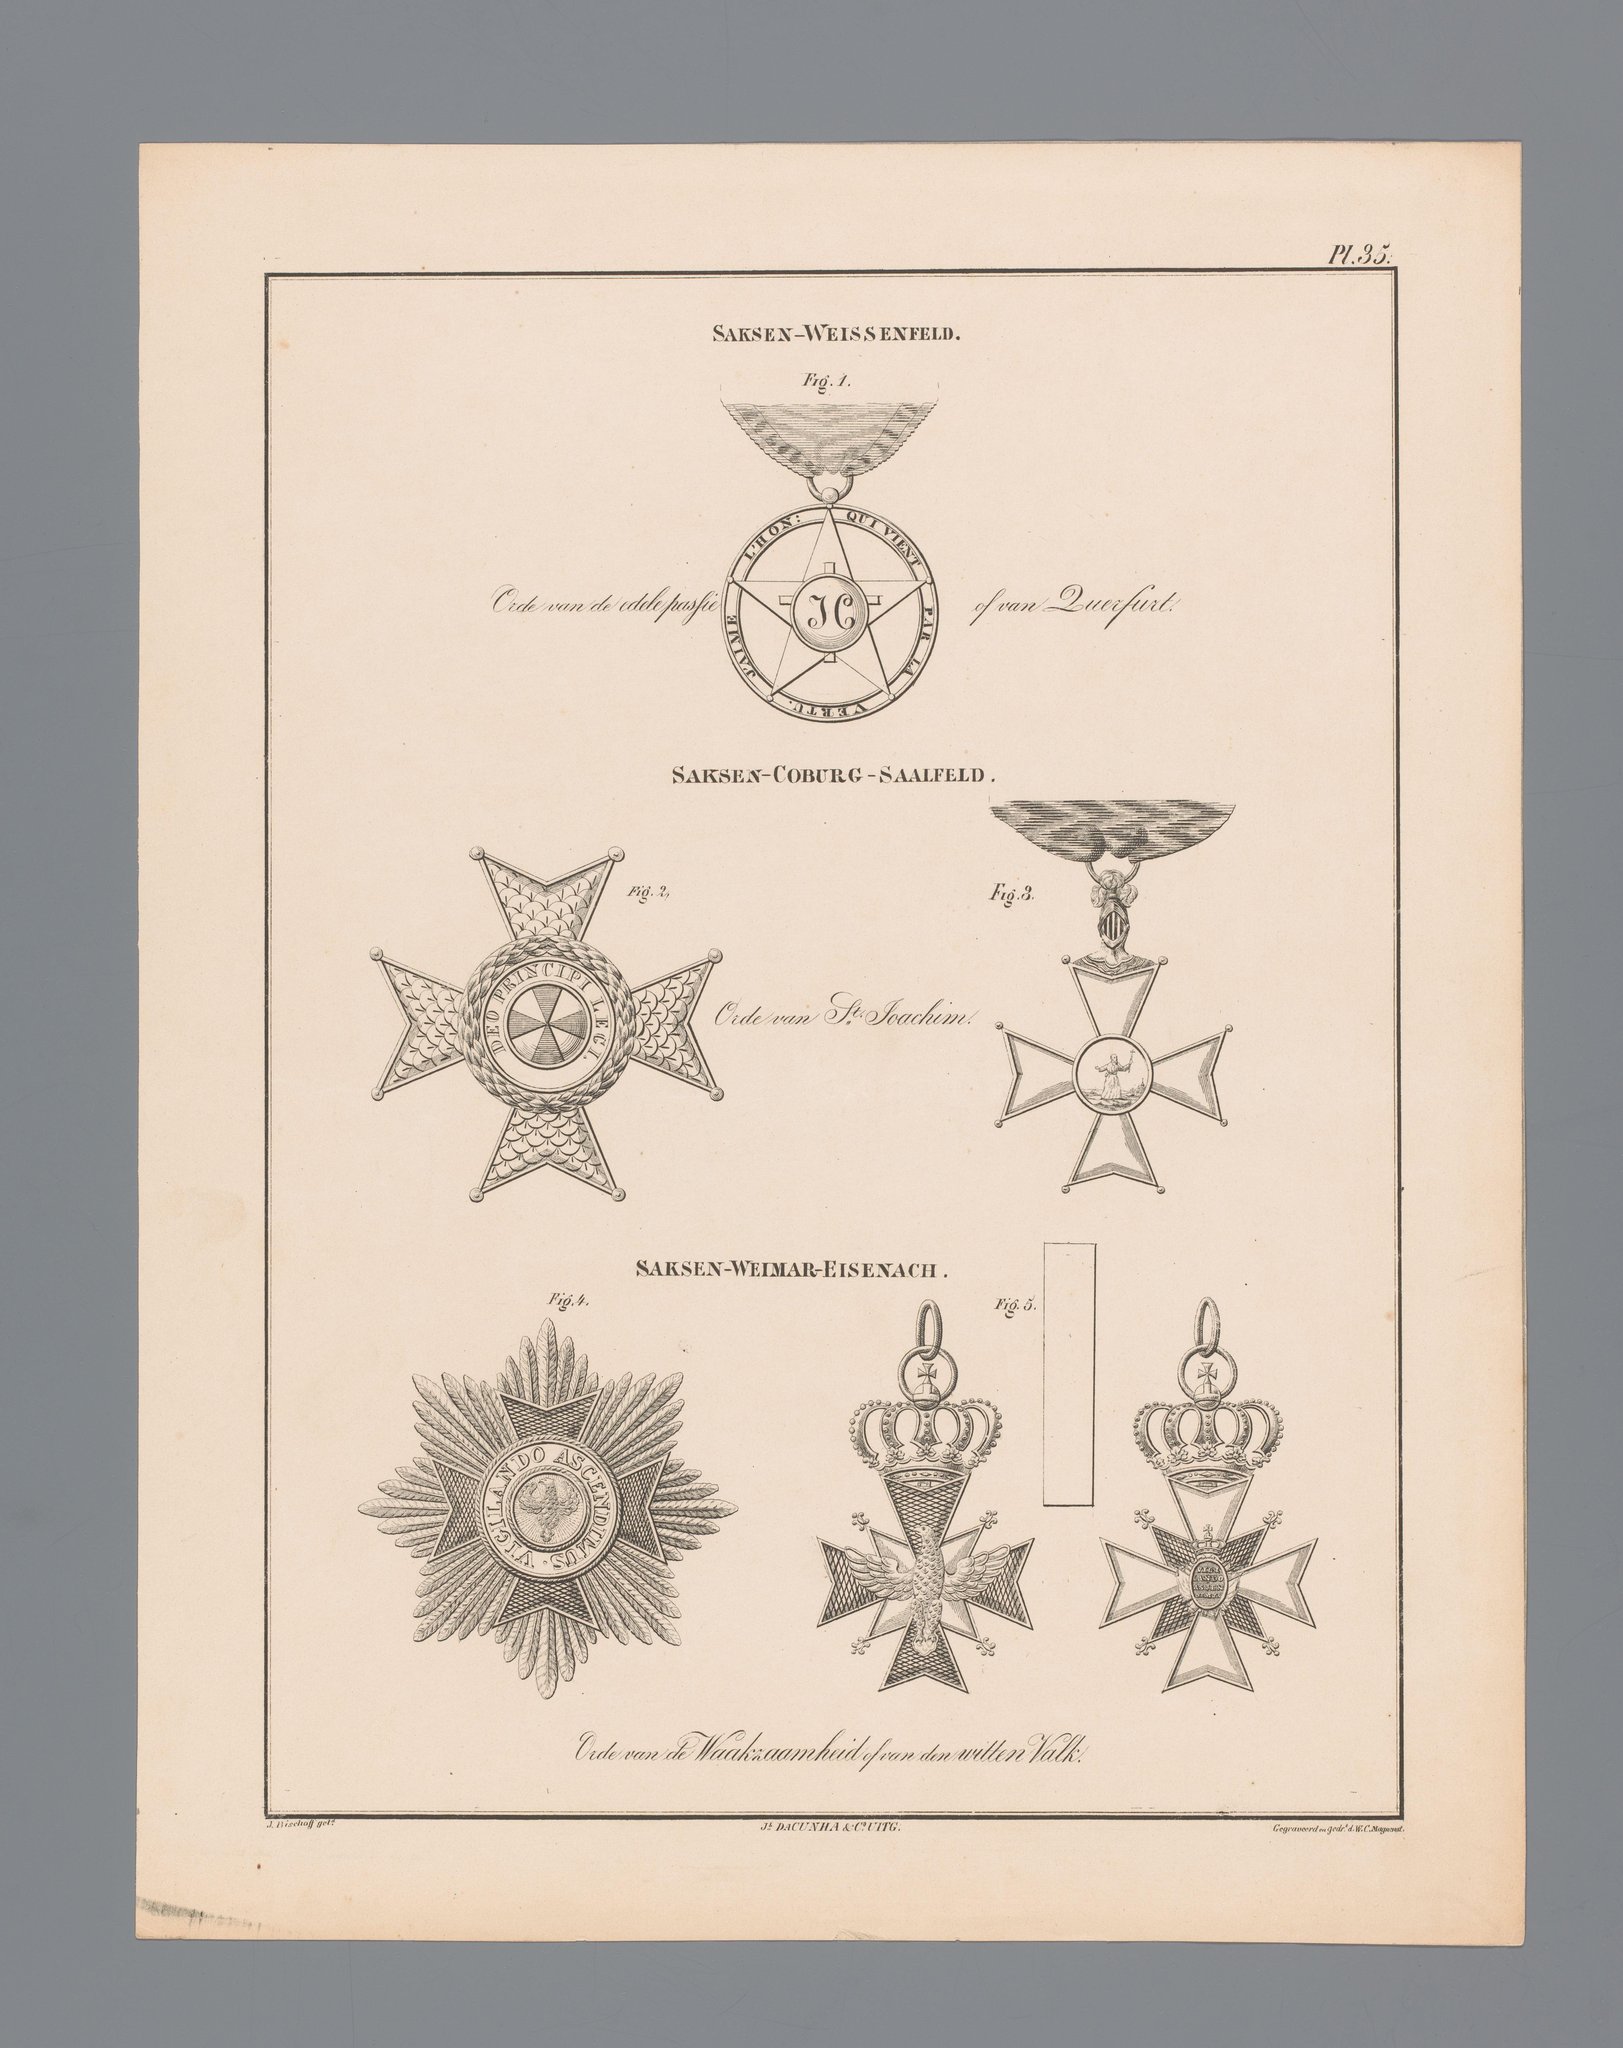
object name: print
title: Ridderorden van Duitse hertogdommen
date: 1843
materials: paper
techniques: lithograph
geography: amsterdam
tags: knighthood order, germany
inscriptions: collector's mark: Lugt 2228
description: Deze prent werd uitgegeven in: G.L. de Rochemont en J. Bischoff, Geschiedkundige beschrijving der oudere en nieuwere, thans bestaande ridderorden, zoo in als buiten Europa (...) Amsterdam, Jb. da Cunha & Co: 1843.